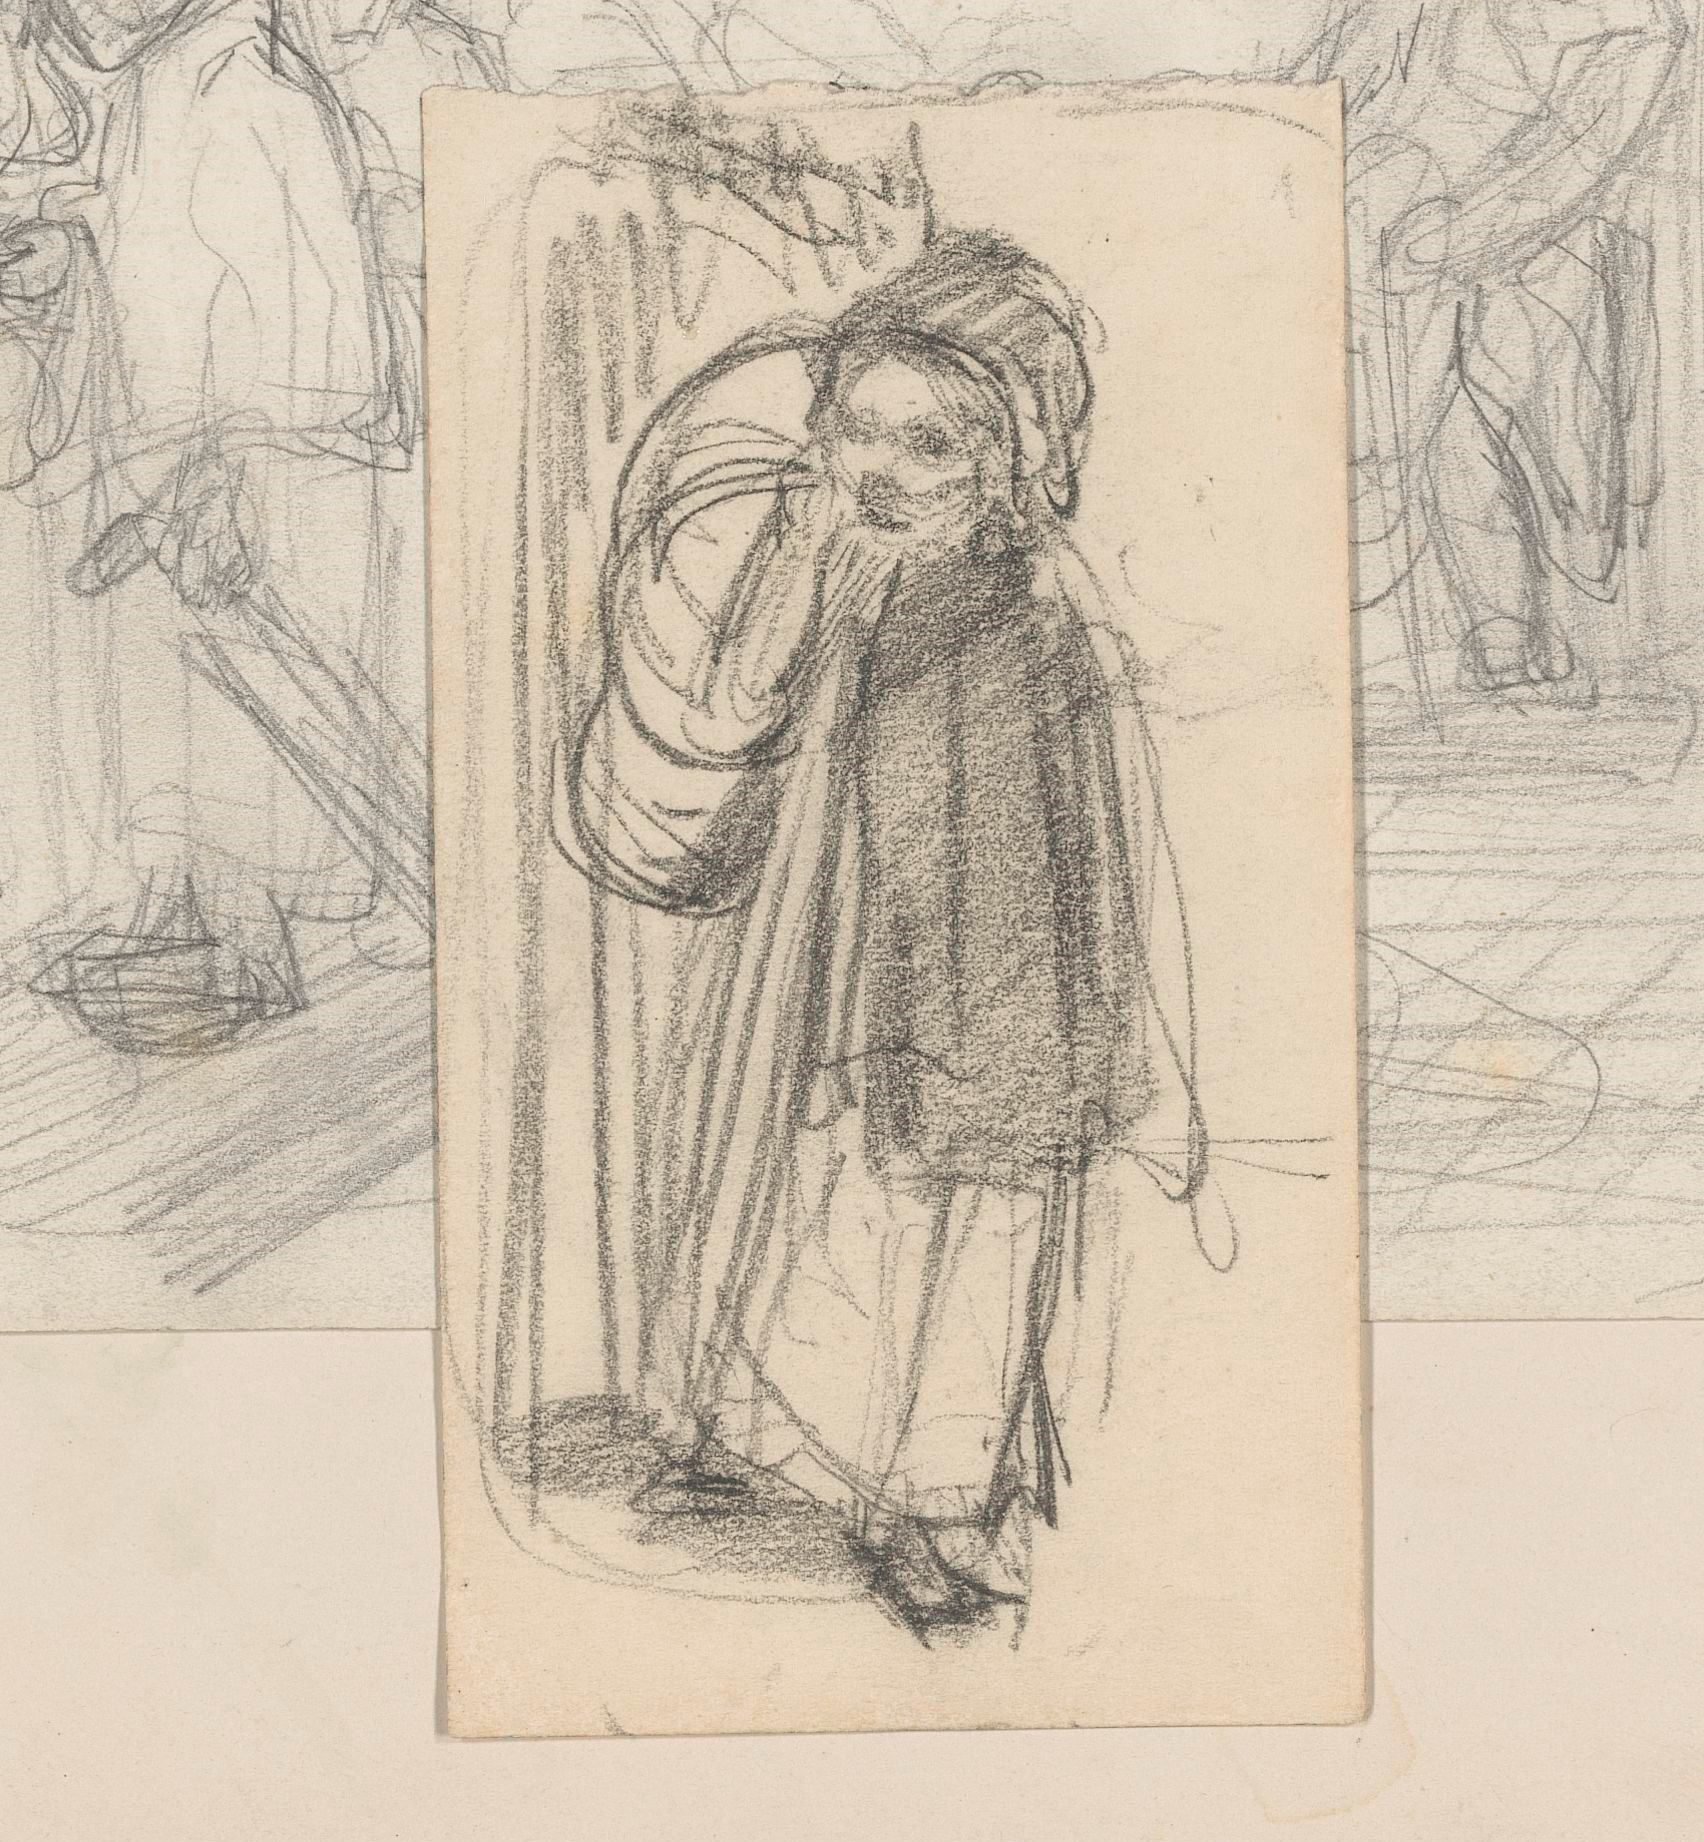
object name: drawing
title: Twee vrouwen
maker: august allebé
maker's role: draughtsman, print maker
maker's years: 1838-1927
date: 1848-1927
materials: paper, pencil